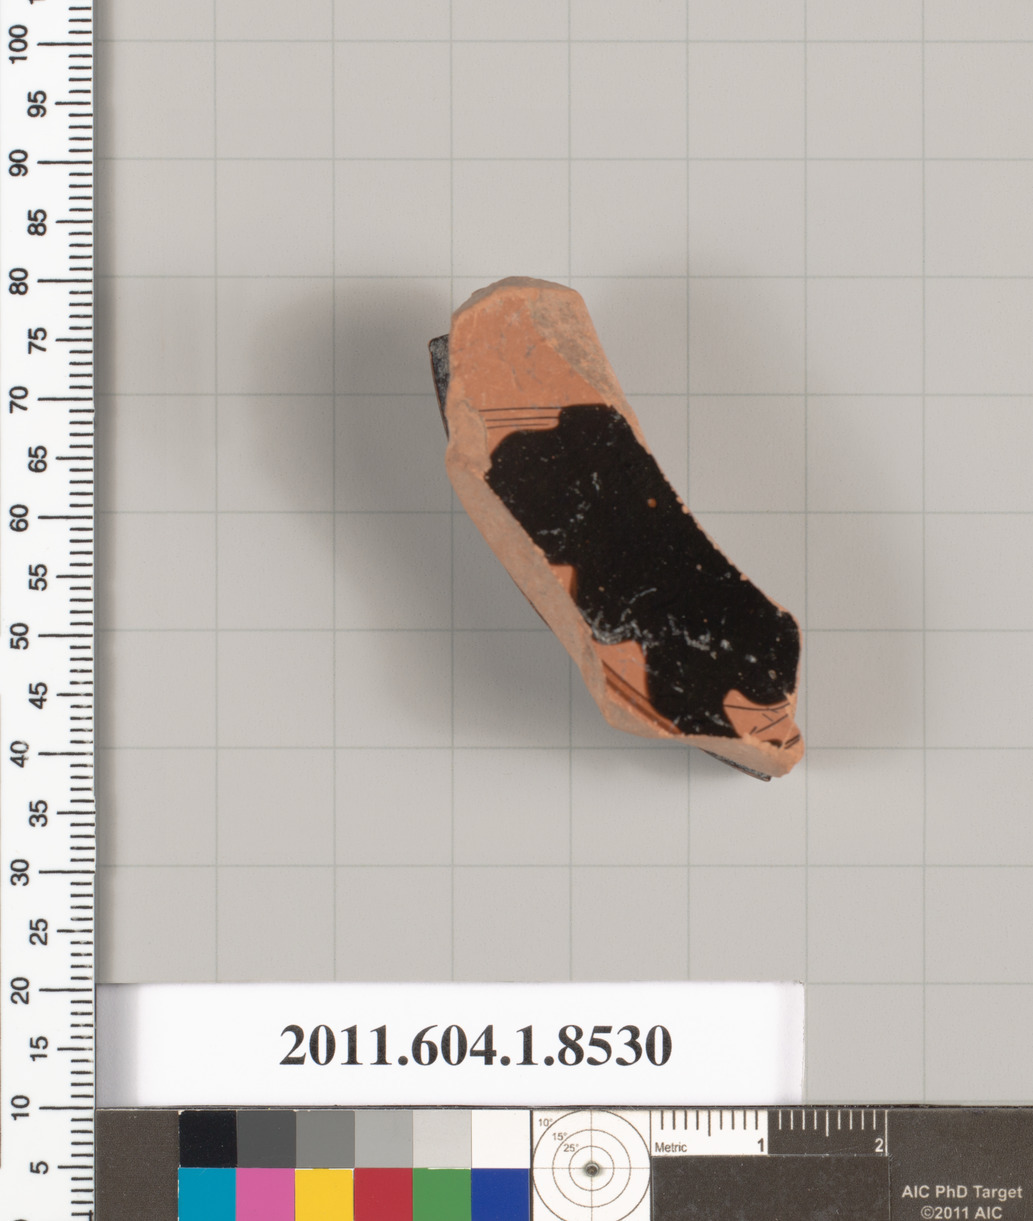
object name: kylix fragment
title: Terracotta fragment of a stemless kylix (drinking cup)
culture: greek, attic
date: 467-435 BCE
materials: terracotta